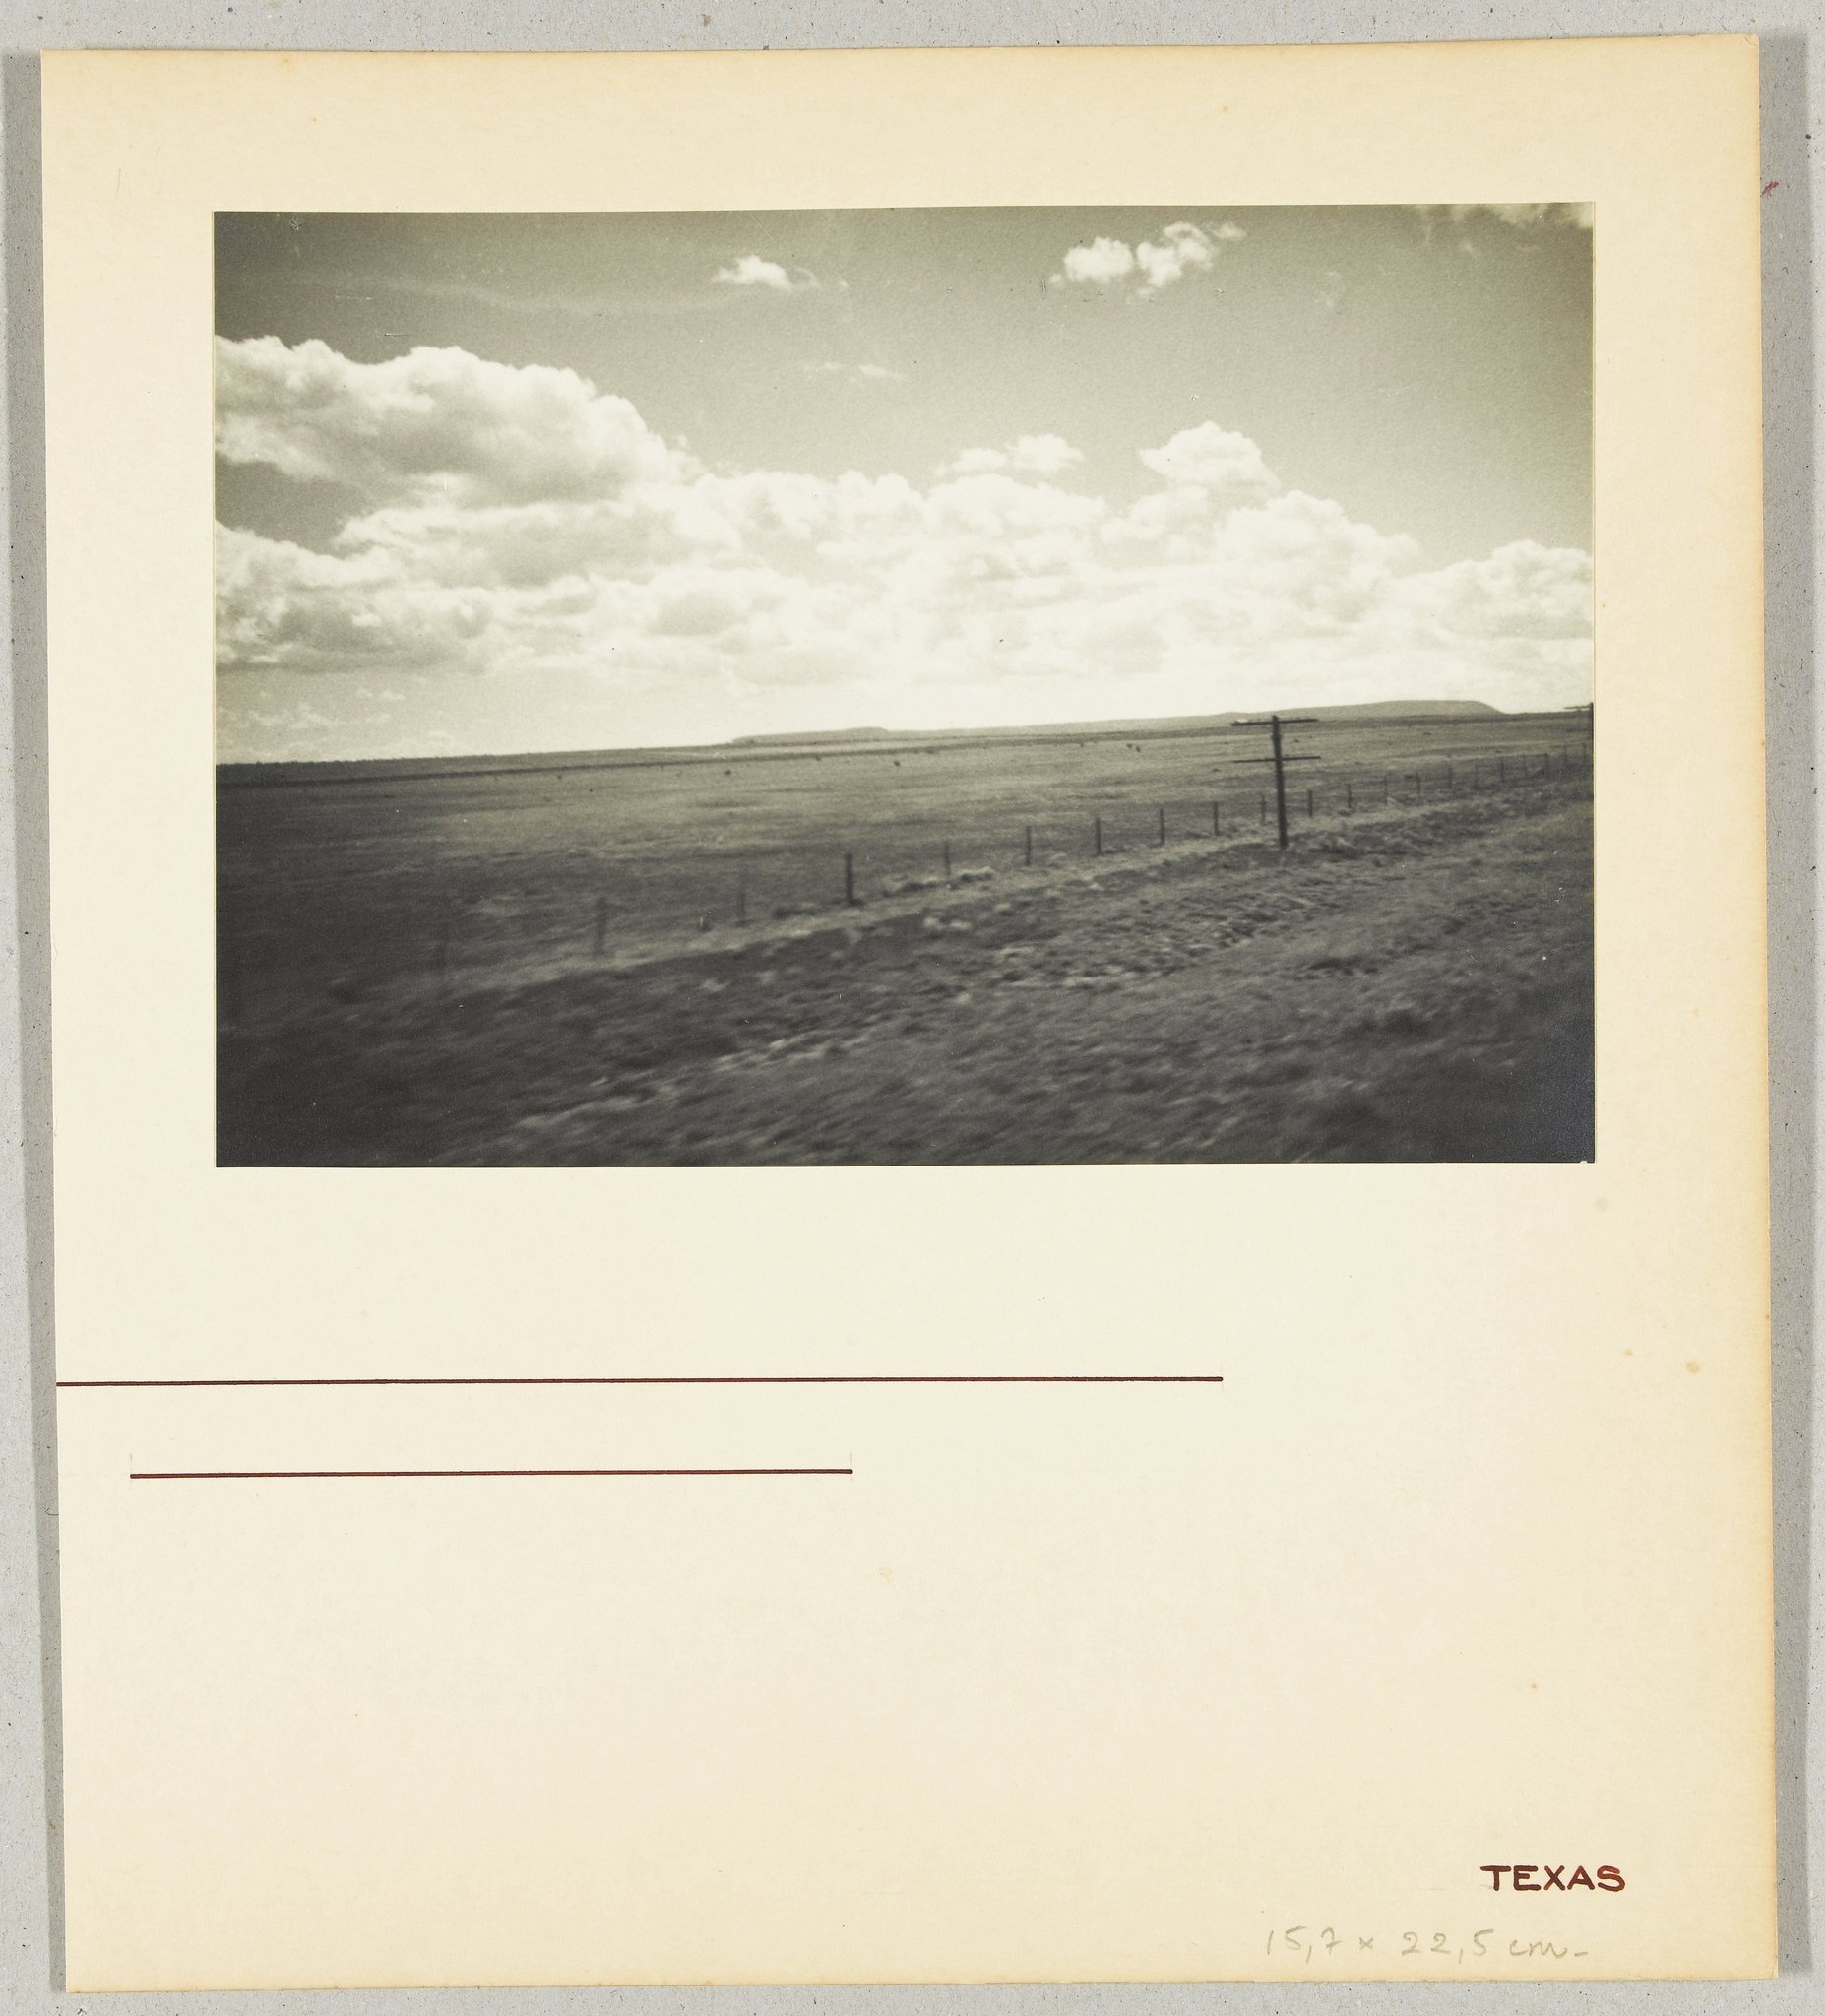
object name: photograph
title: Landschap in Texas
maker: wouter cool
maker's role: engineer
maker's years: 1877-1947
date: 1936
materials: cardboard, paper, photographic support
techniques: gelatin silver print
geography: united states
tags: landscapes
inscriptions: title: ‘TEXAS’